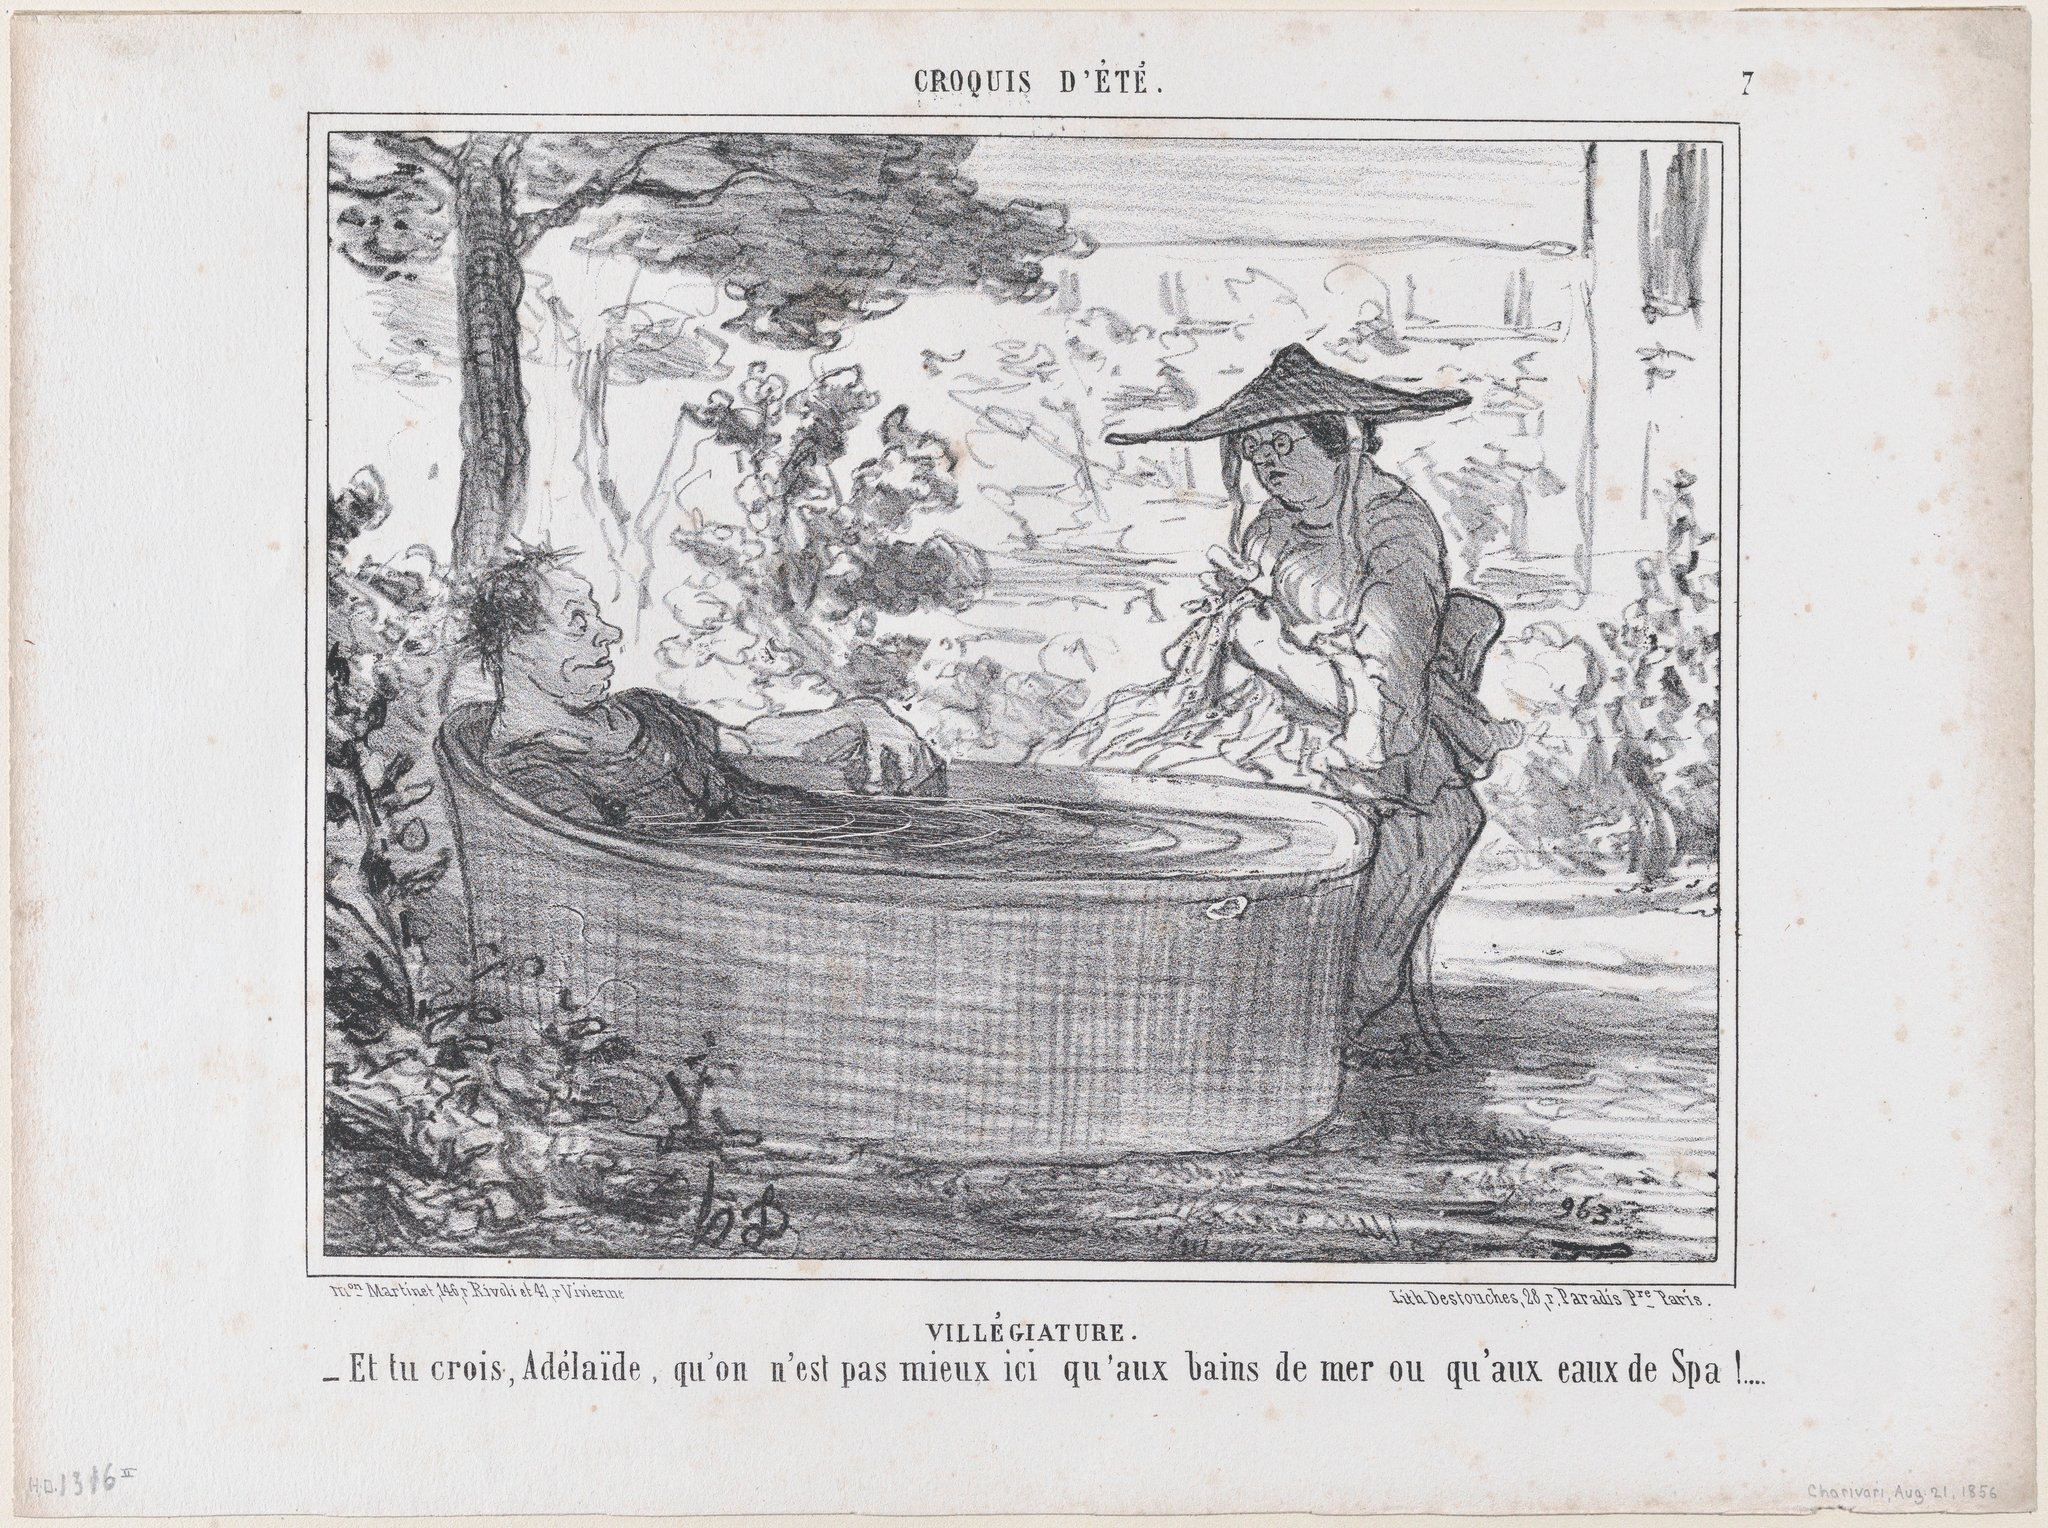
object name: print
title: Villégiature, from Croquis d'Été, published in Le Charivari, August 22, 1856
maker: honoré daumier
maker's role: artist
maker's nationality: french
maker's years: 1808-1879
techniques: lithograph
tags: men,women,trees,summer,bathing